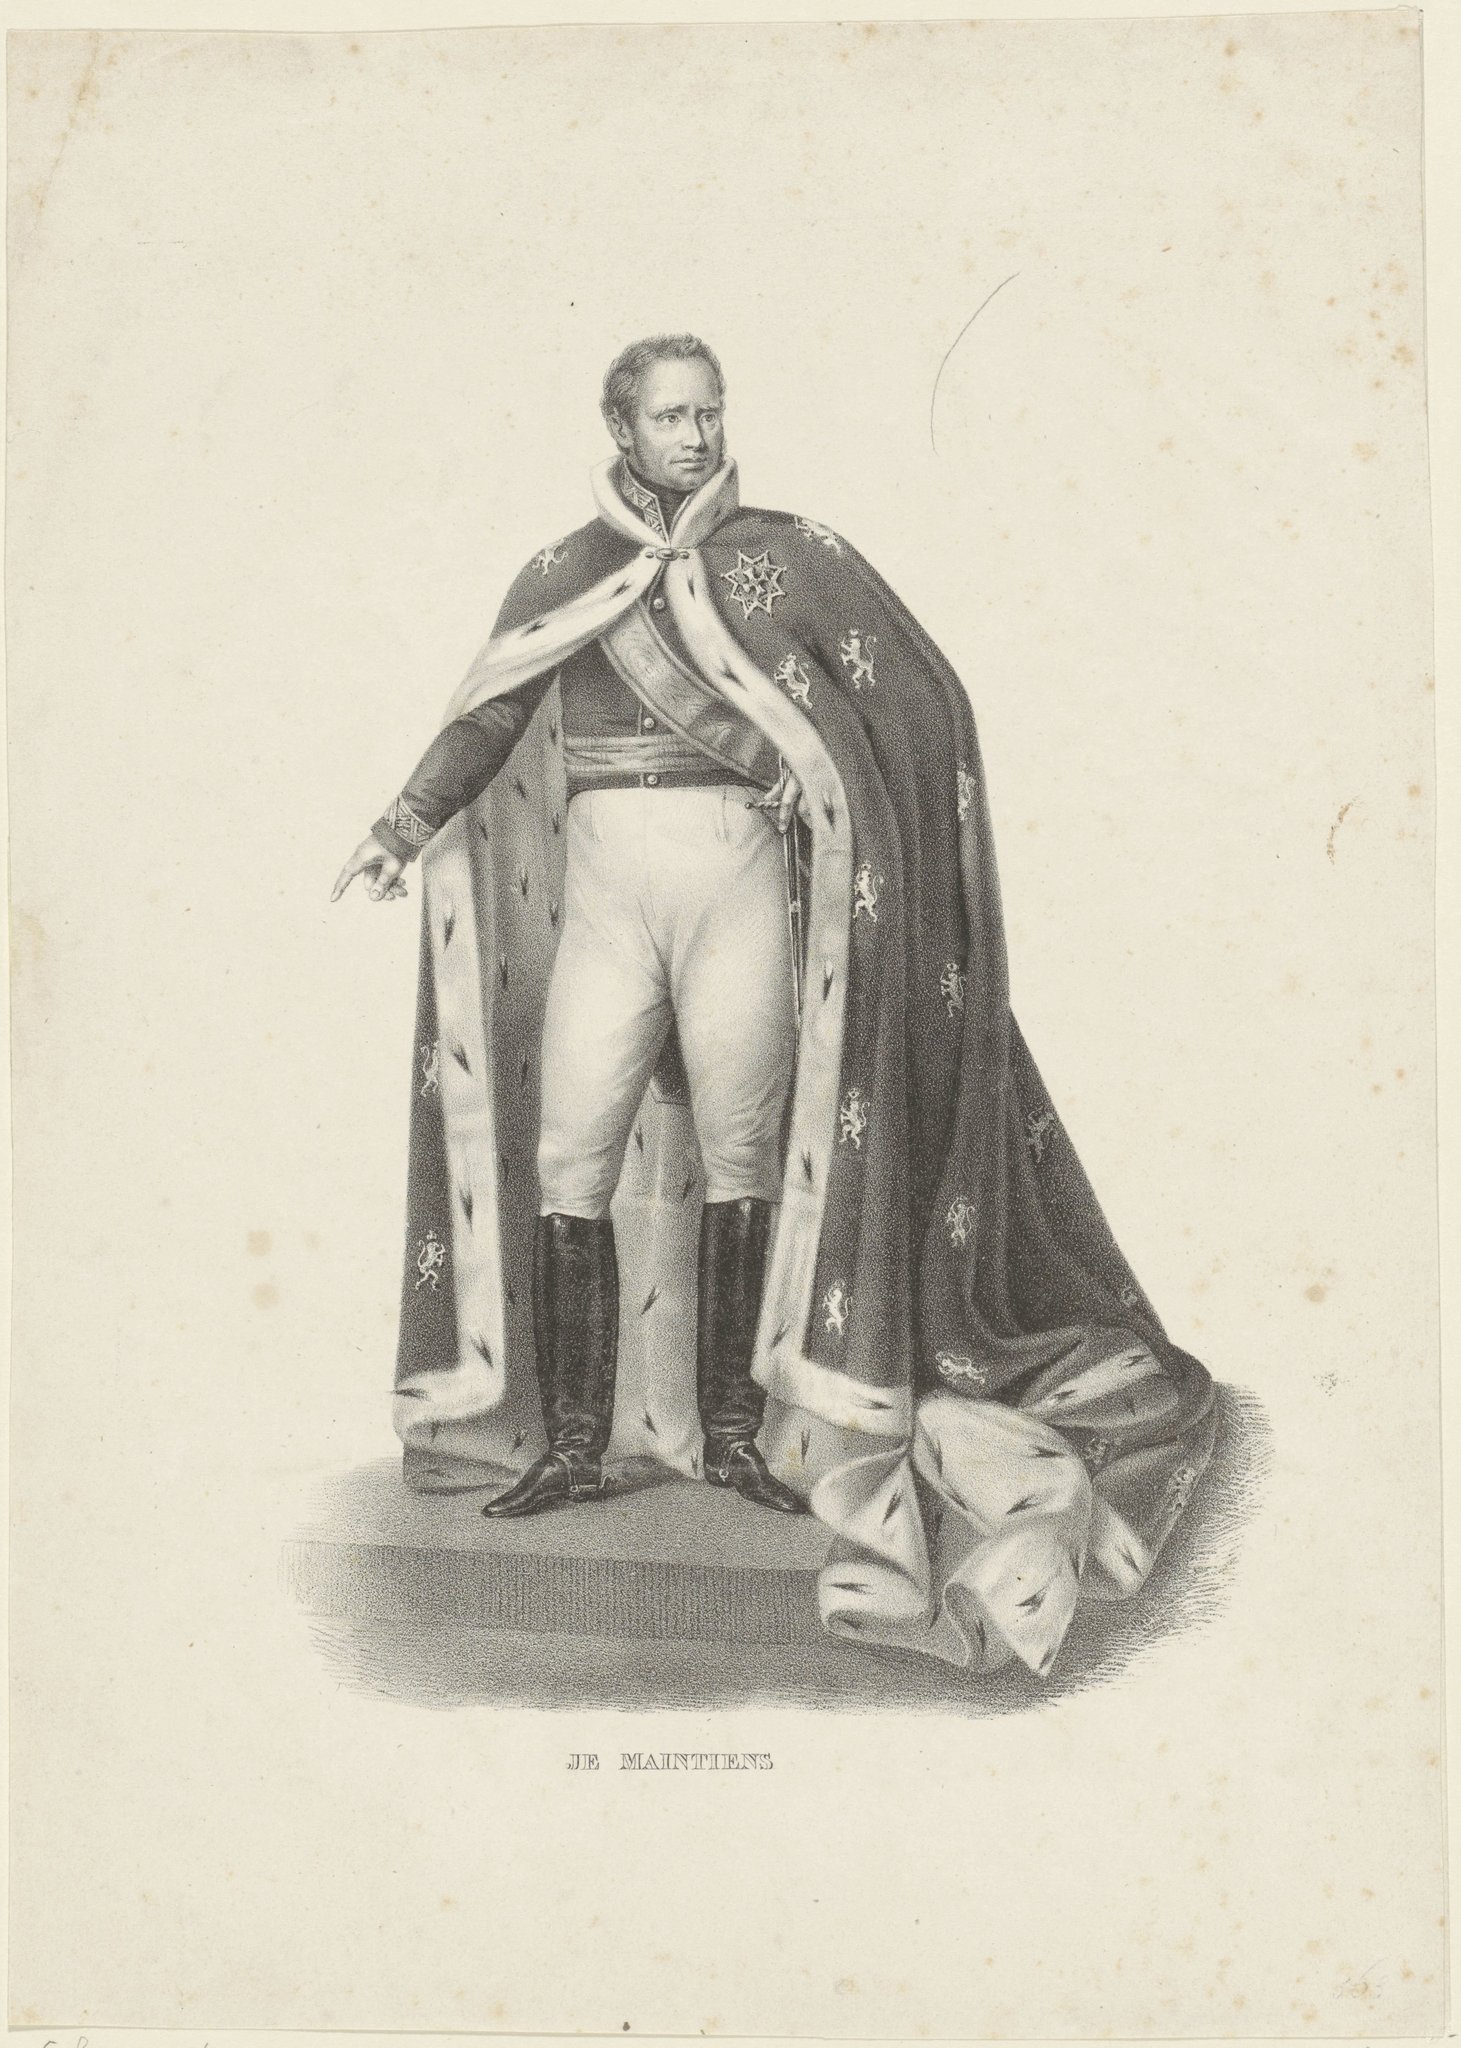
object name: print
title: Portret van Willem I Frederik, koning der Nederlanden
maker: Anonymous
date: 1815-1899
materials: paper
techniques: lithograph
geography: netherlands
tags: the hague, berlin, william i of the netherlands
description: De hier vermelde titel verwijst naar de hoogst verkregen titel van de geportretteerde, niet per se naar de titel die de geportretteerde op deze voorstelling draagt.